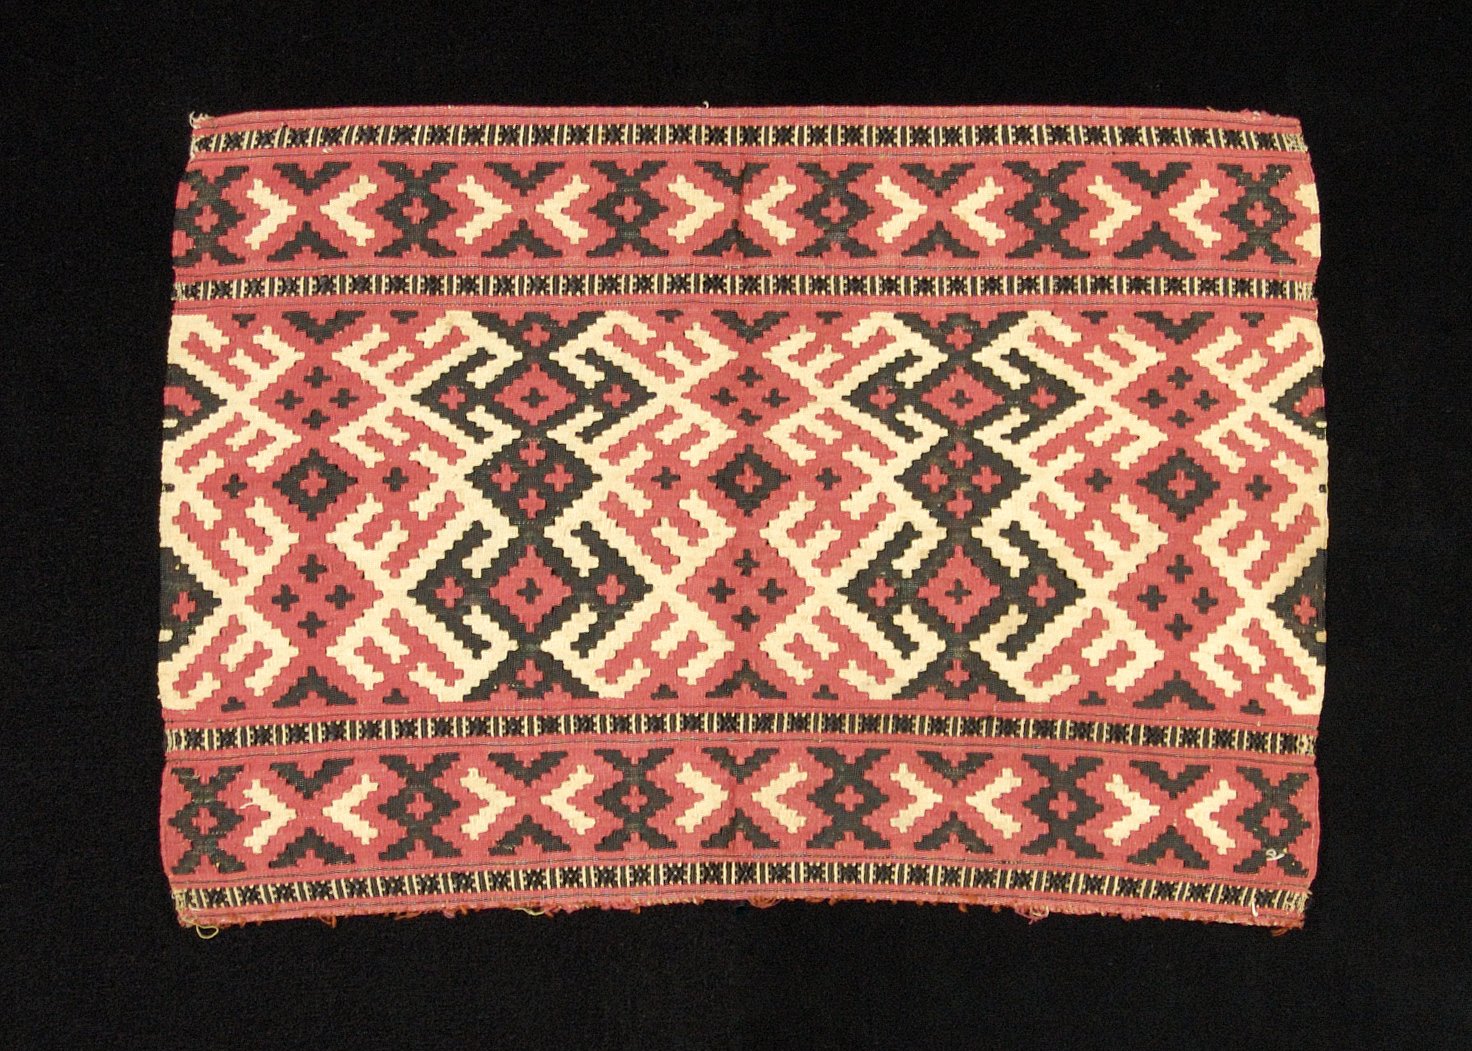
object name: textile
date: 1840-1870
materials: silk